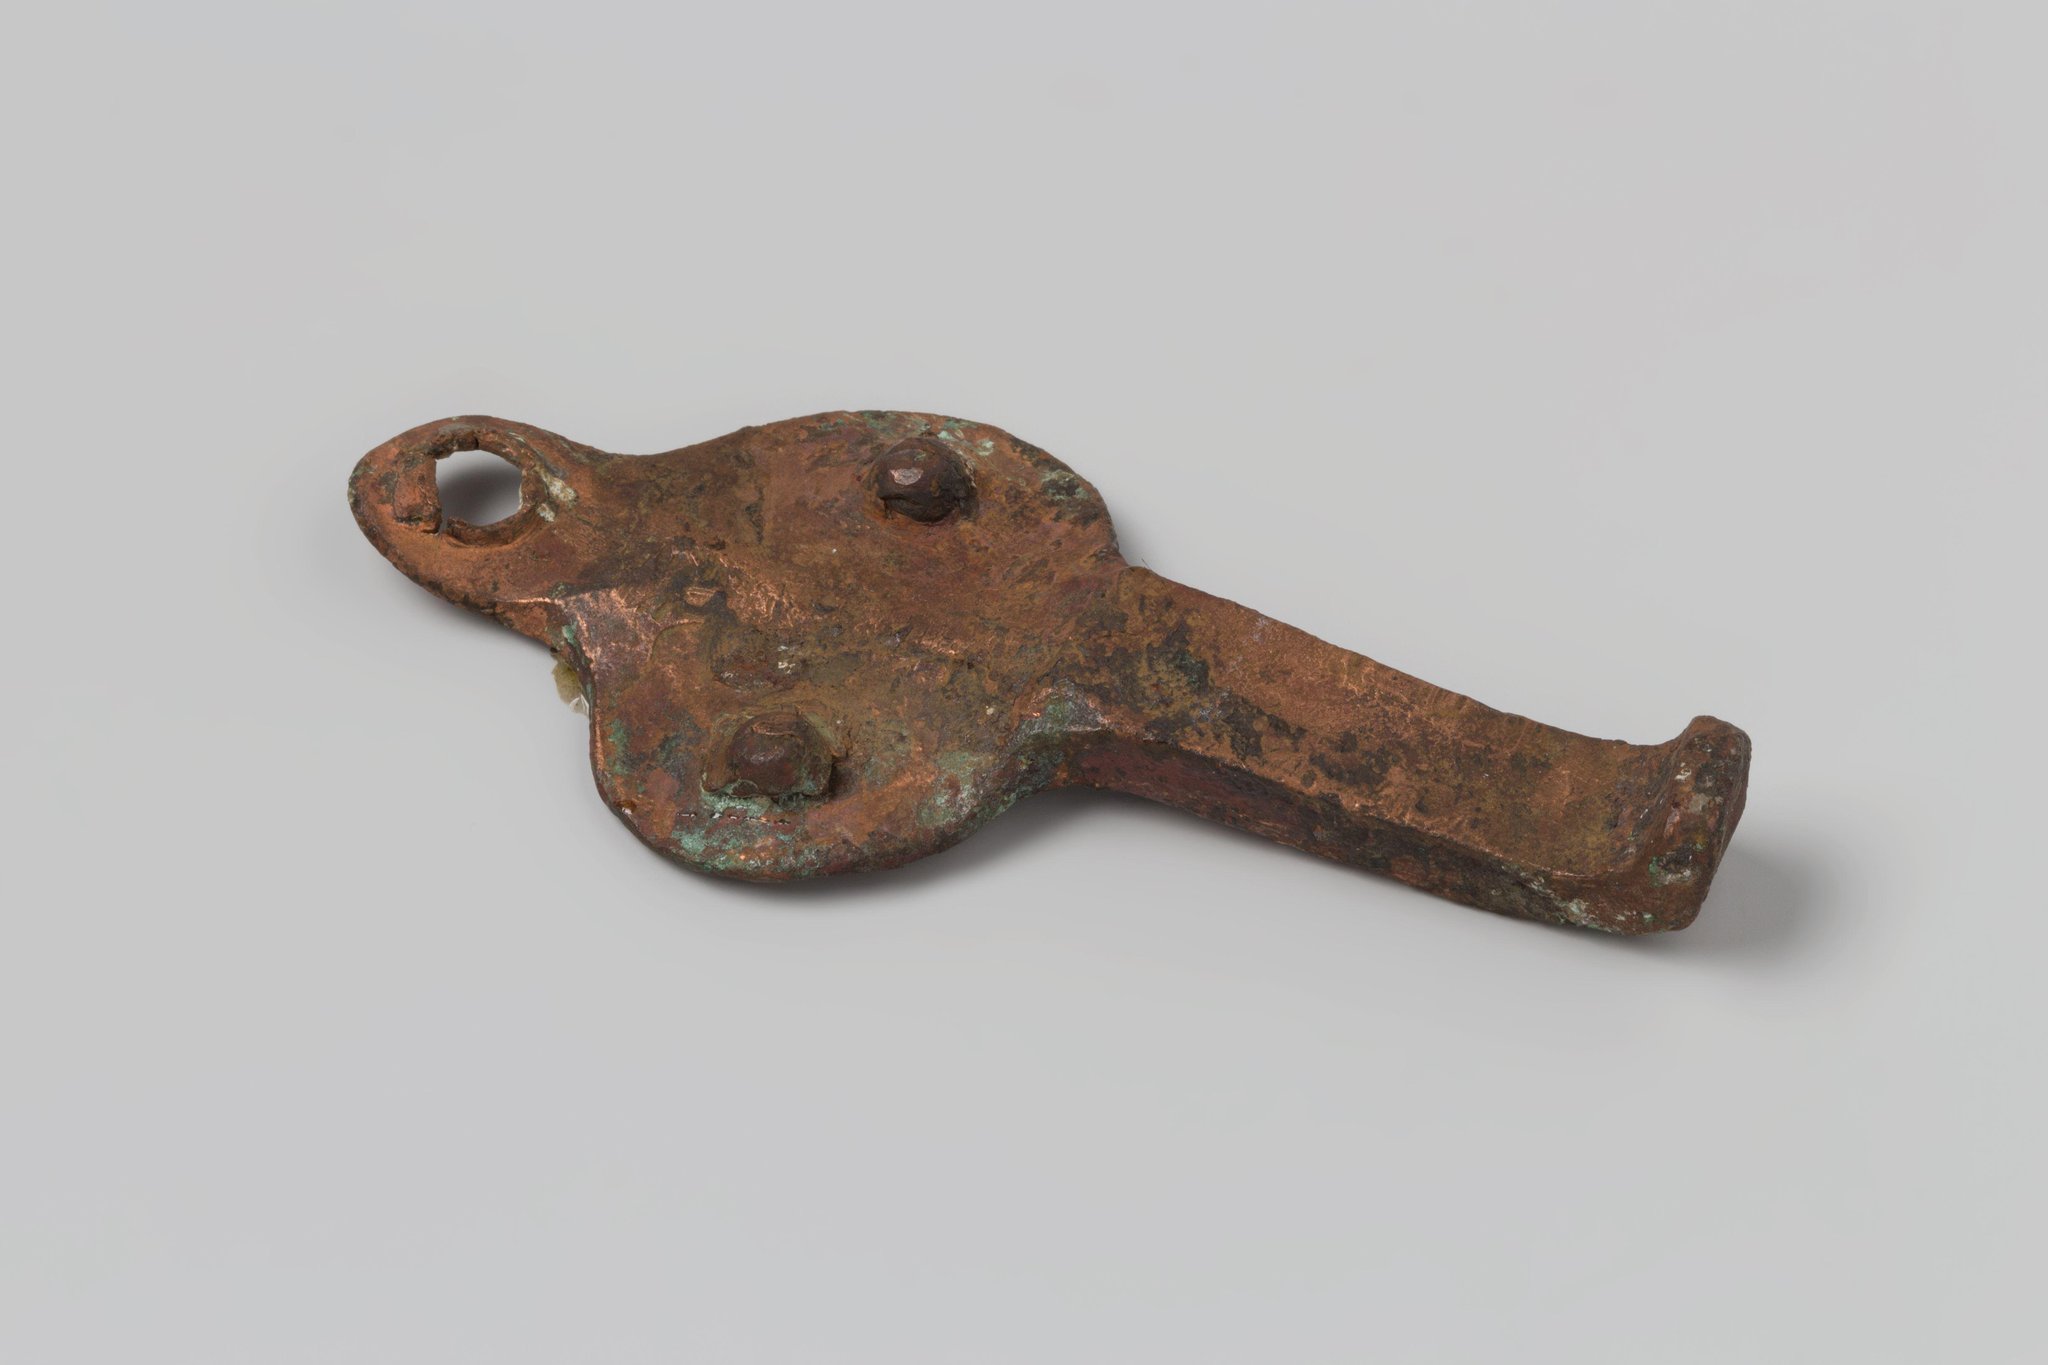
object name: leg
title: Vastgeklonken poot van een verpakking uit het wrak van de Oost-Indiëvaarder Hollandia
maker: Anonymous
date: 1700-1743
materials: copper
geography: netherlands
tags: verenigde oostindische compagnie, hollandia (schip), annet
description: Container, leg, revited; (1) straight, slightly tapering, rectangular in section, three-lobed upper end (c.6l), 3 rivets (one missing).